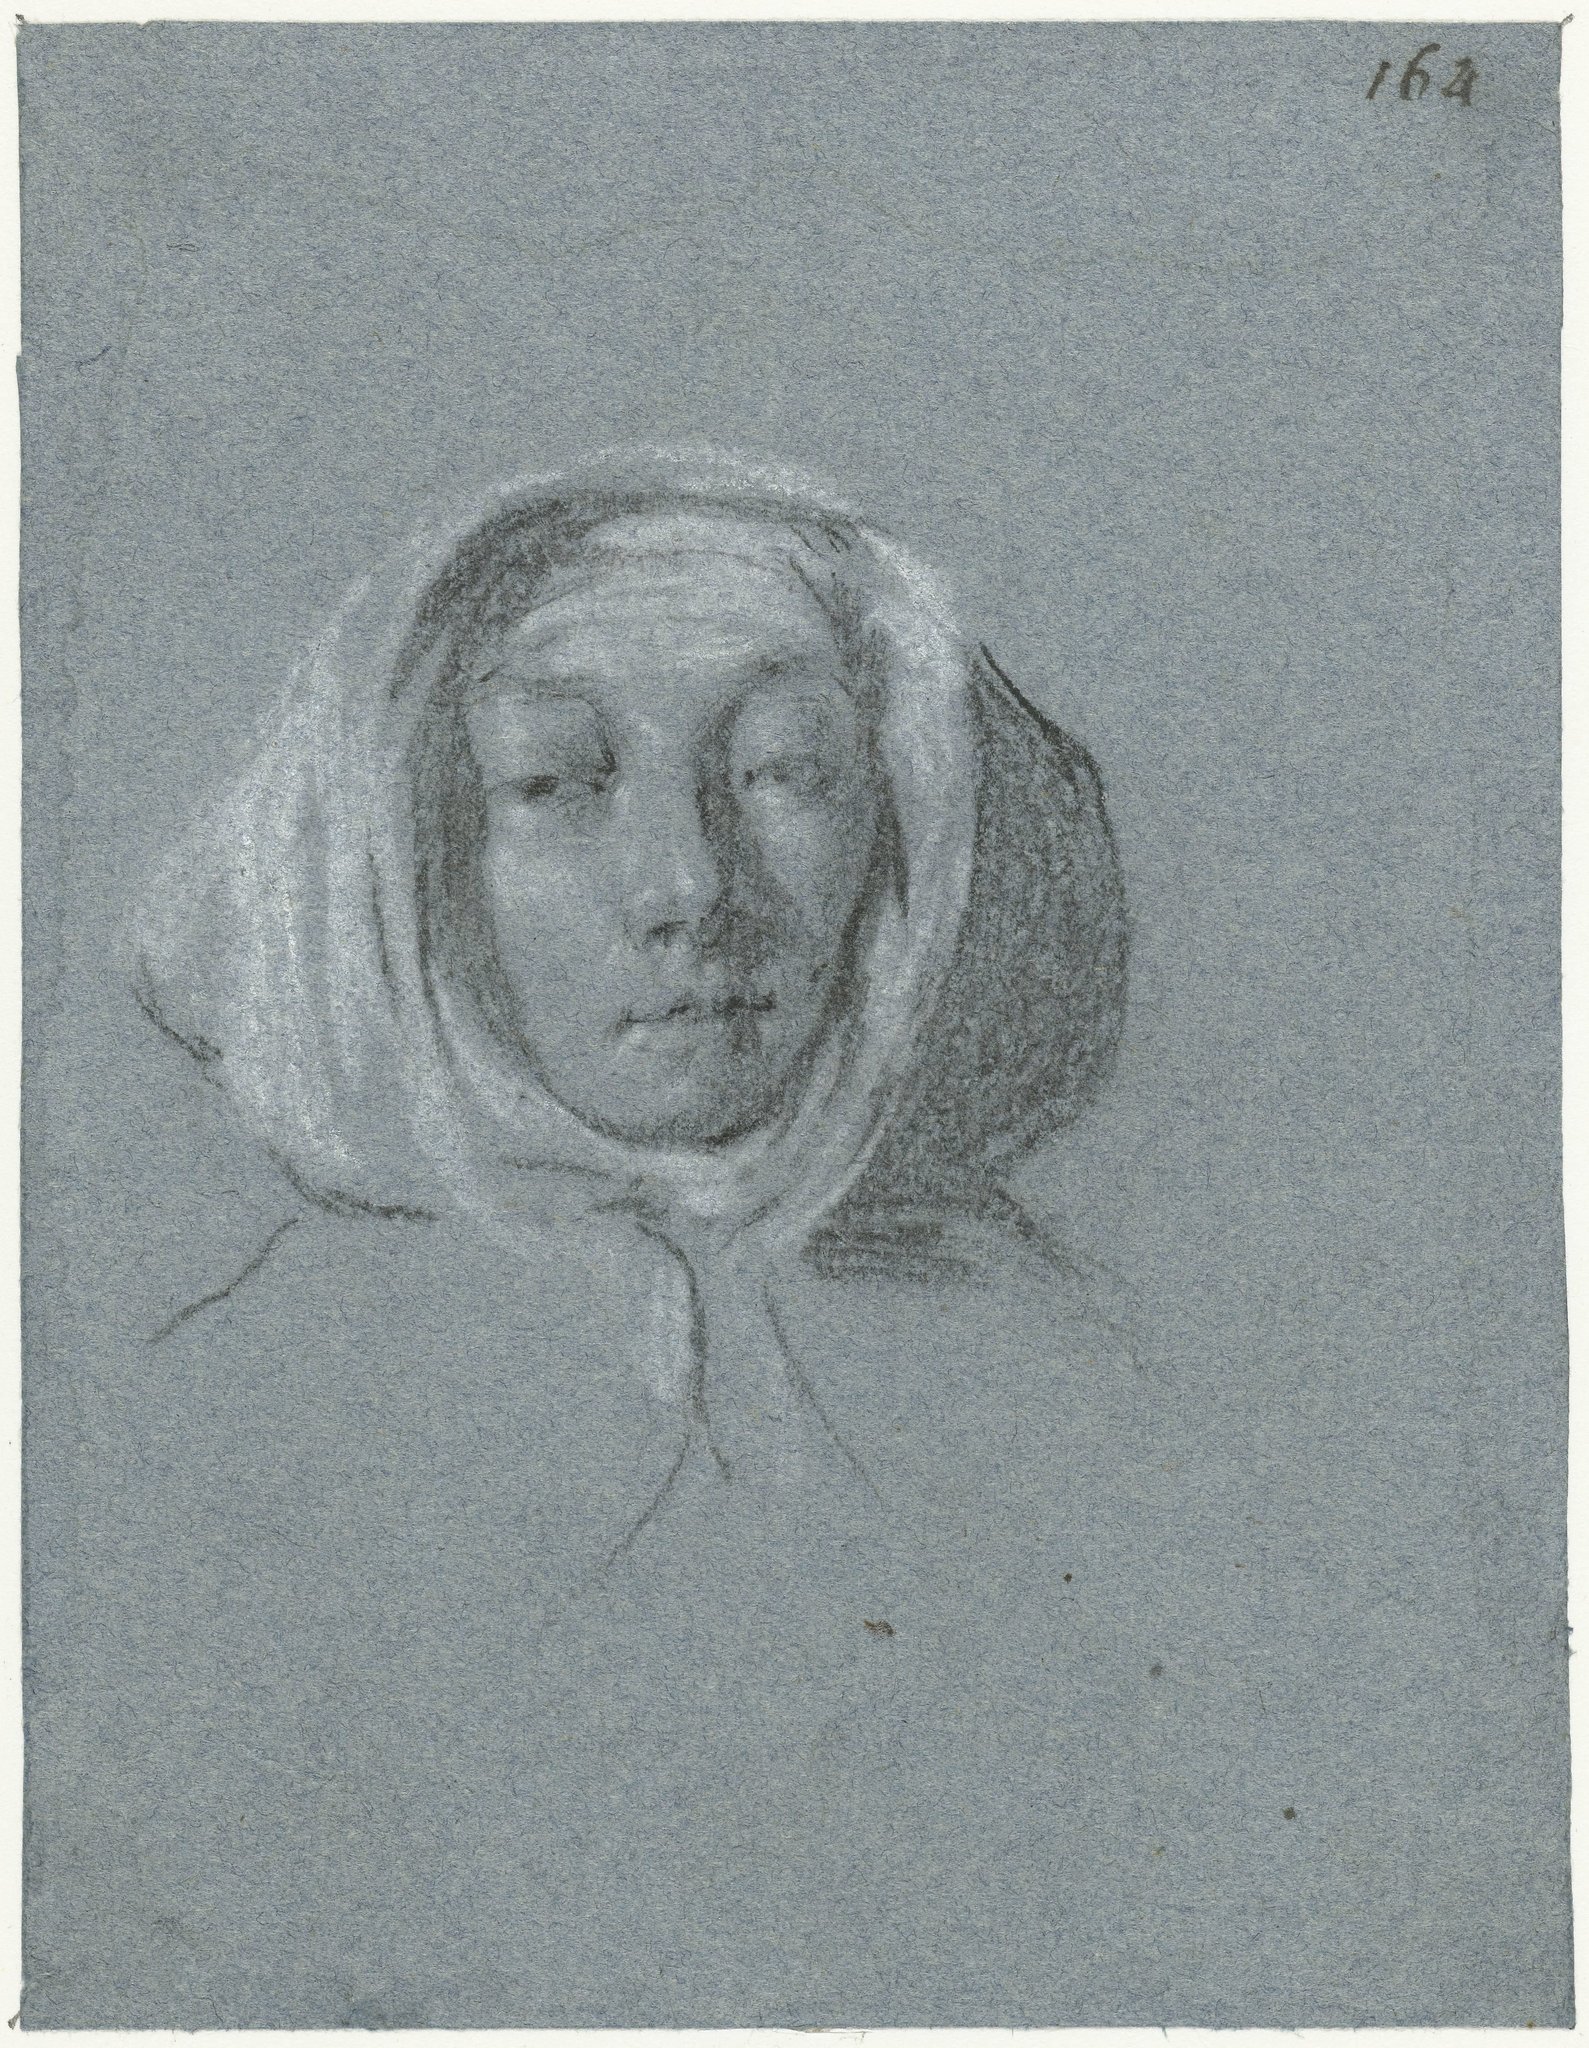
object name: drawing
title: Hoofd van vrouw met hoofddoek, vooruit kijkend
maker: moses ter borch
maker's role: draughtsman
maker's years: 1645-1667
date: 1660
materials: chalk, ink, paper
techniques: brush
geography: zwolle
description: Hoofd van vrouw met hoofddoek, vooruit kijkend; op verso een schetsje van het gezicht van een oude man met een baard.